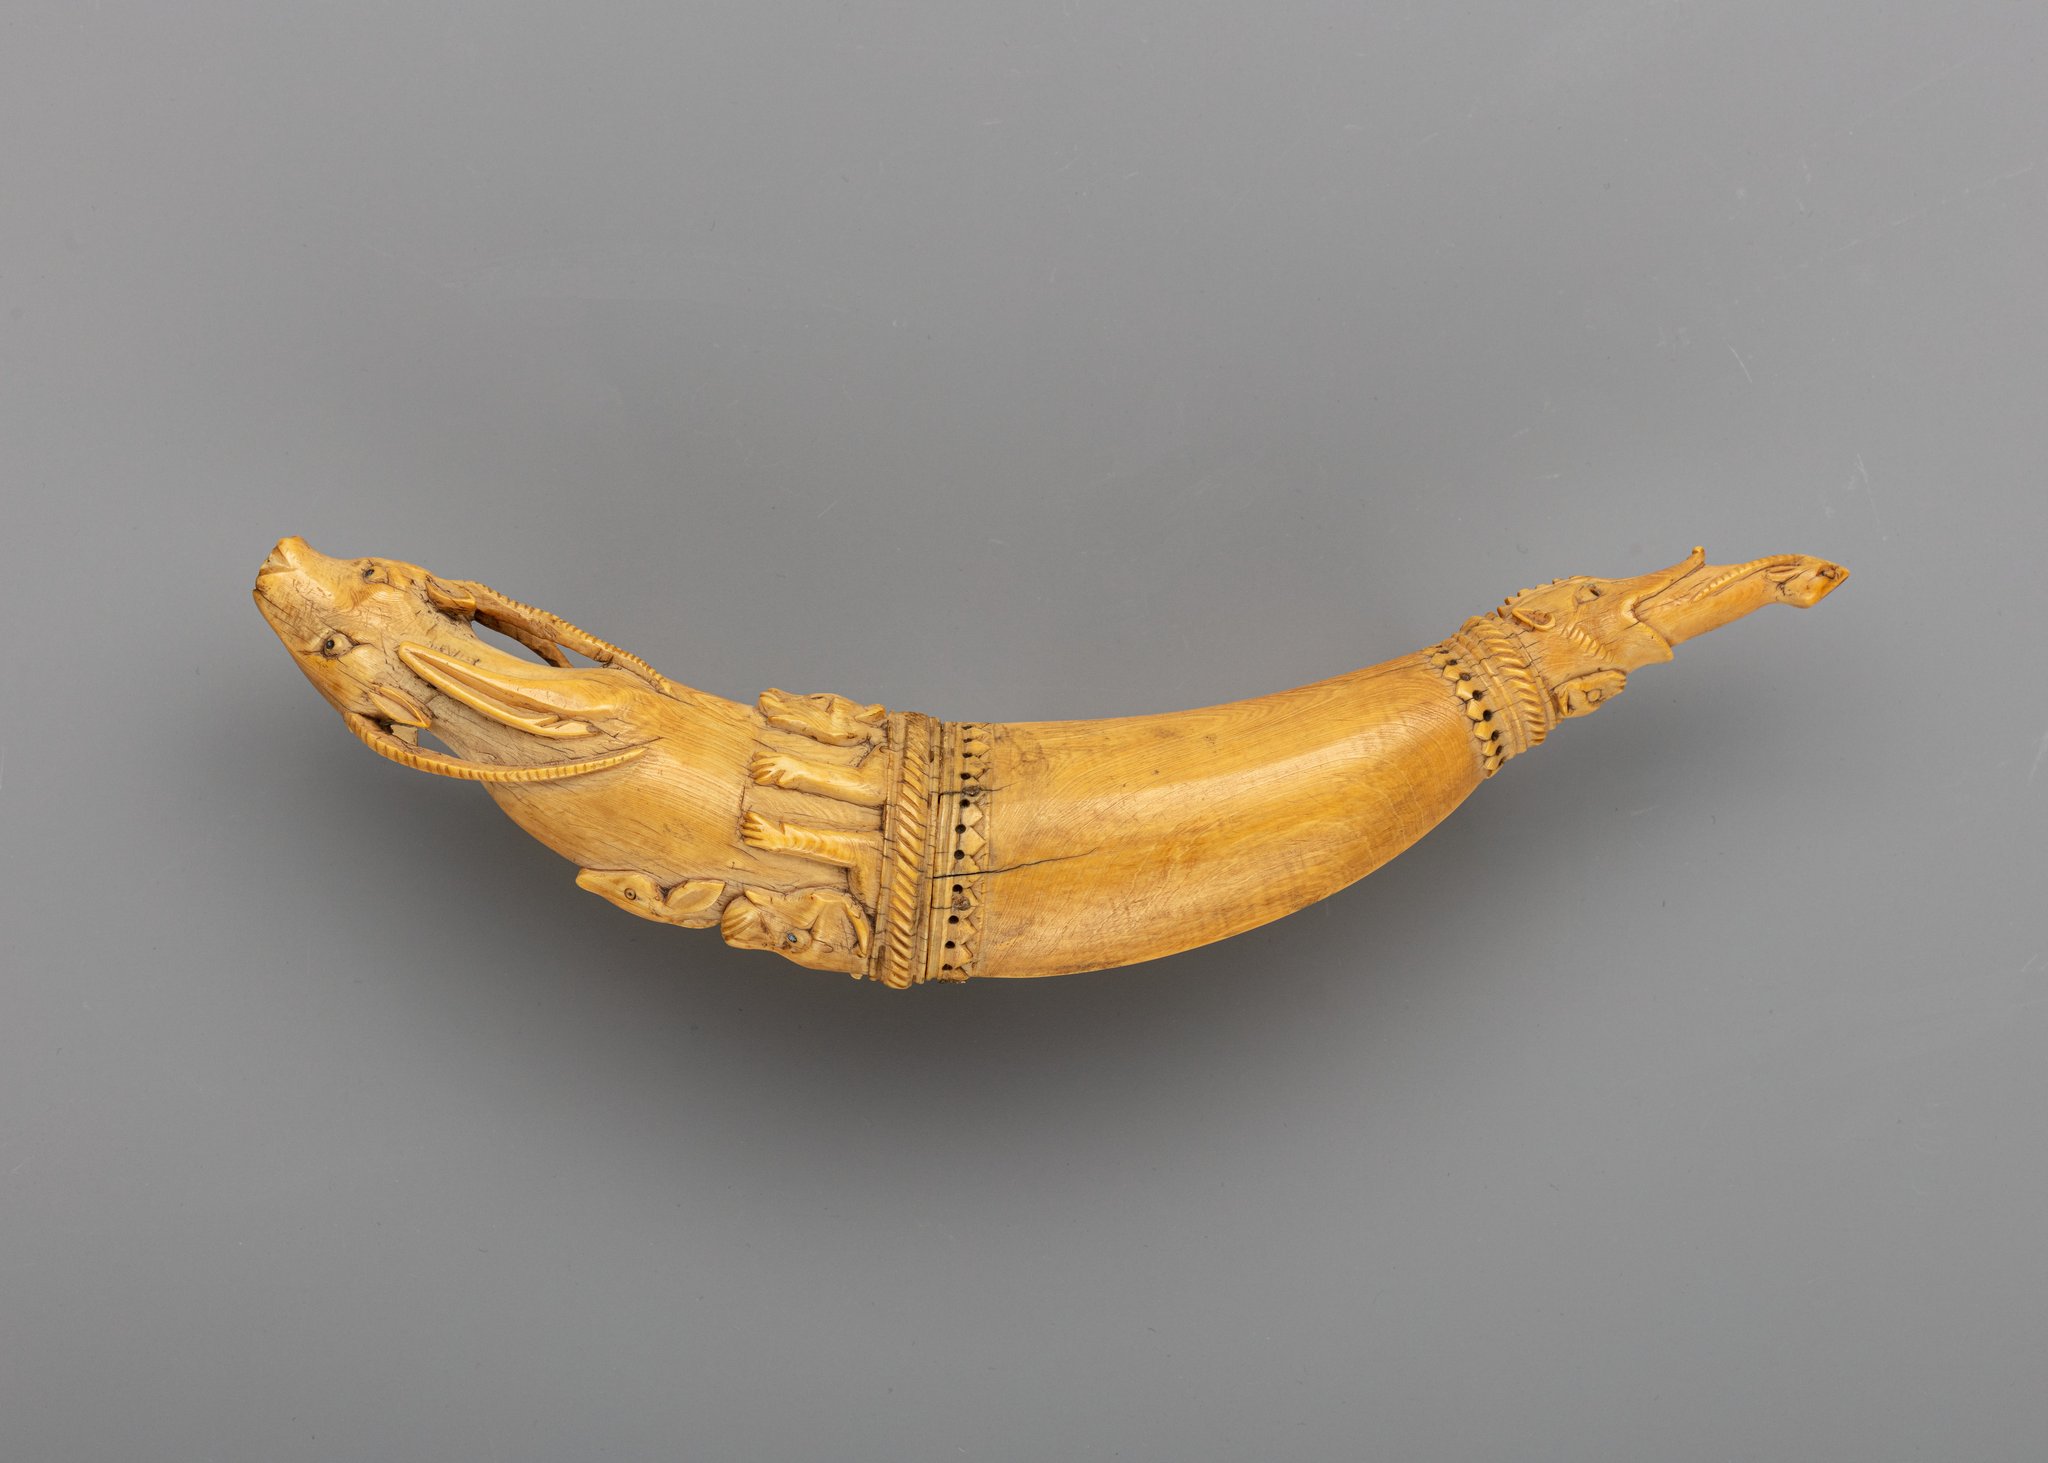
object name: priming flask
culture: indian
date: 1601-1800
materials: ivory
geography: india